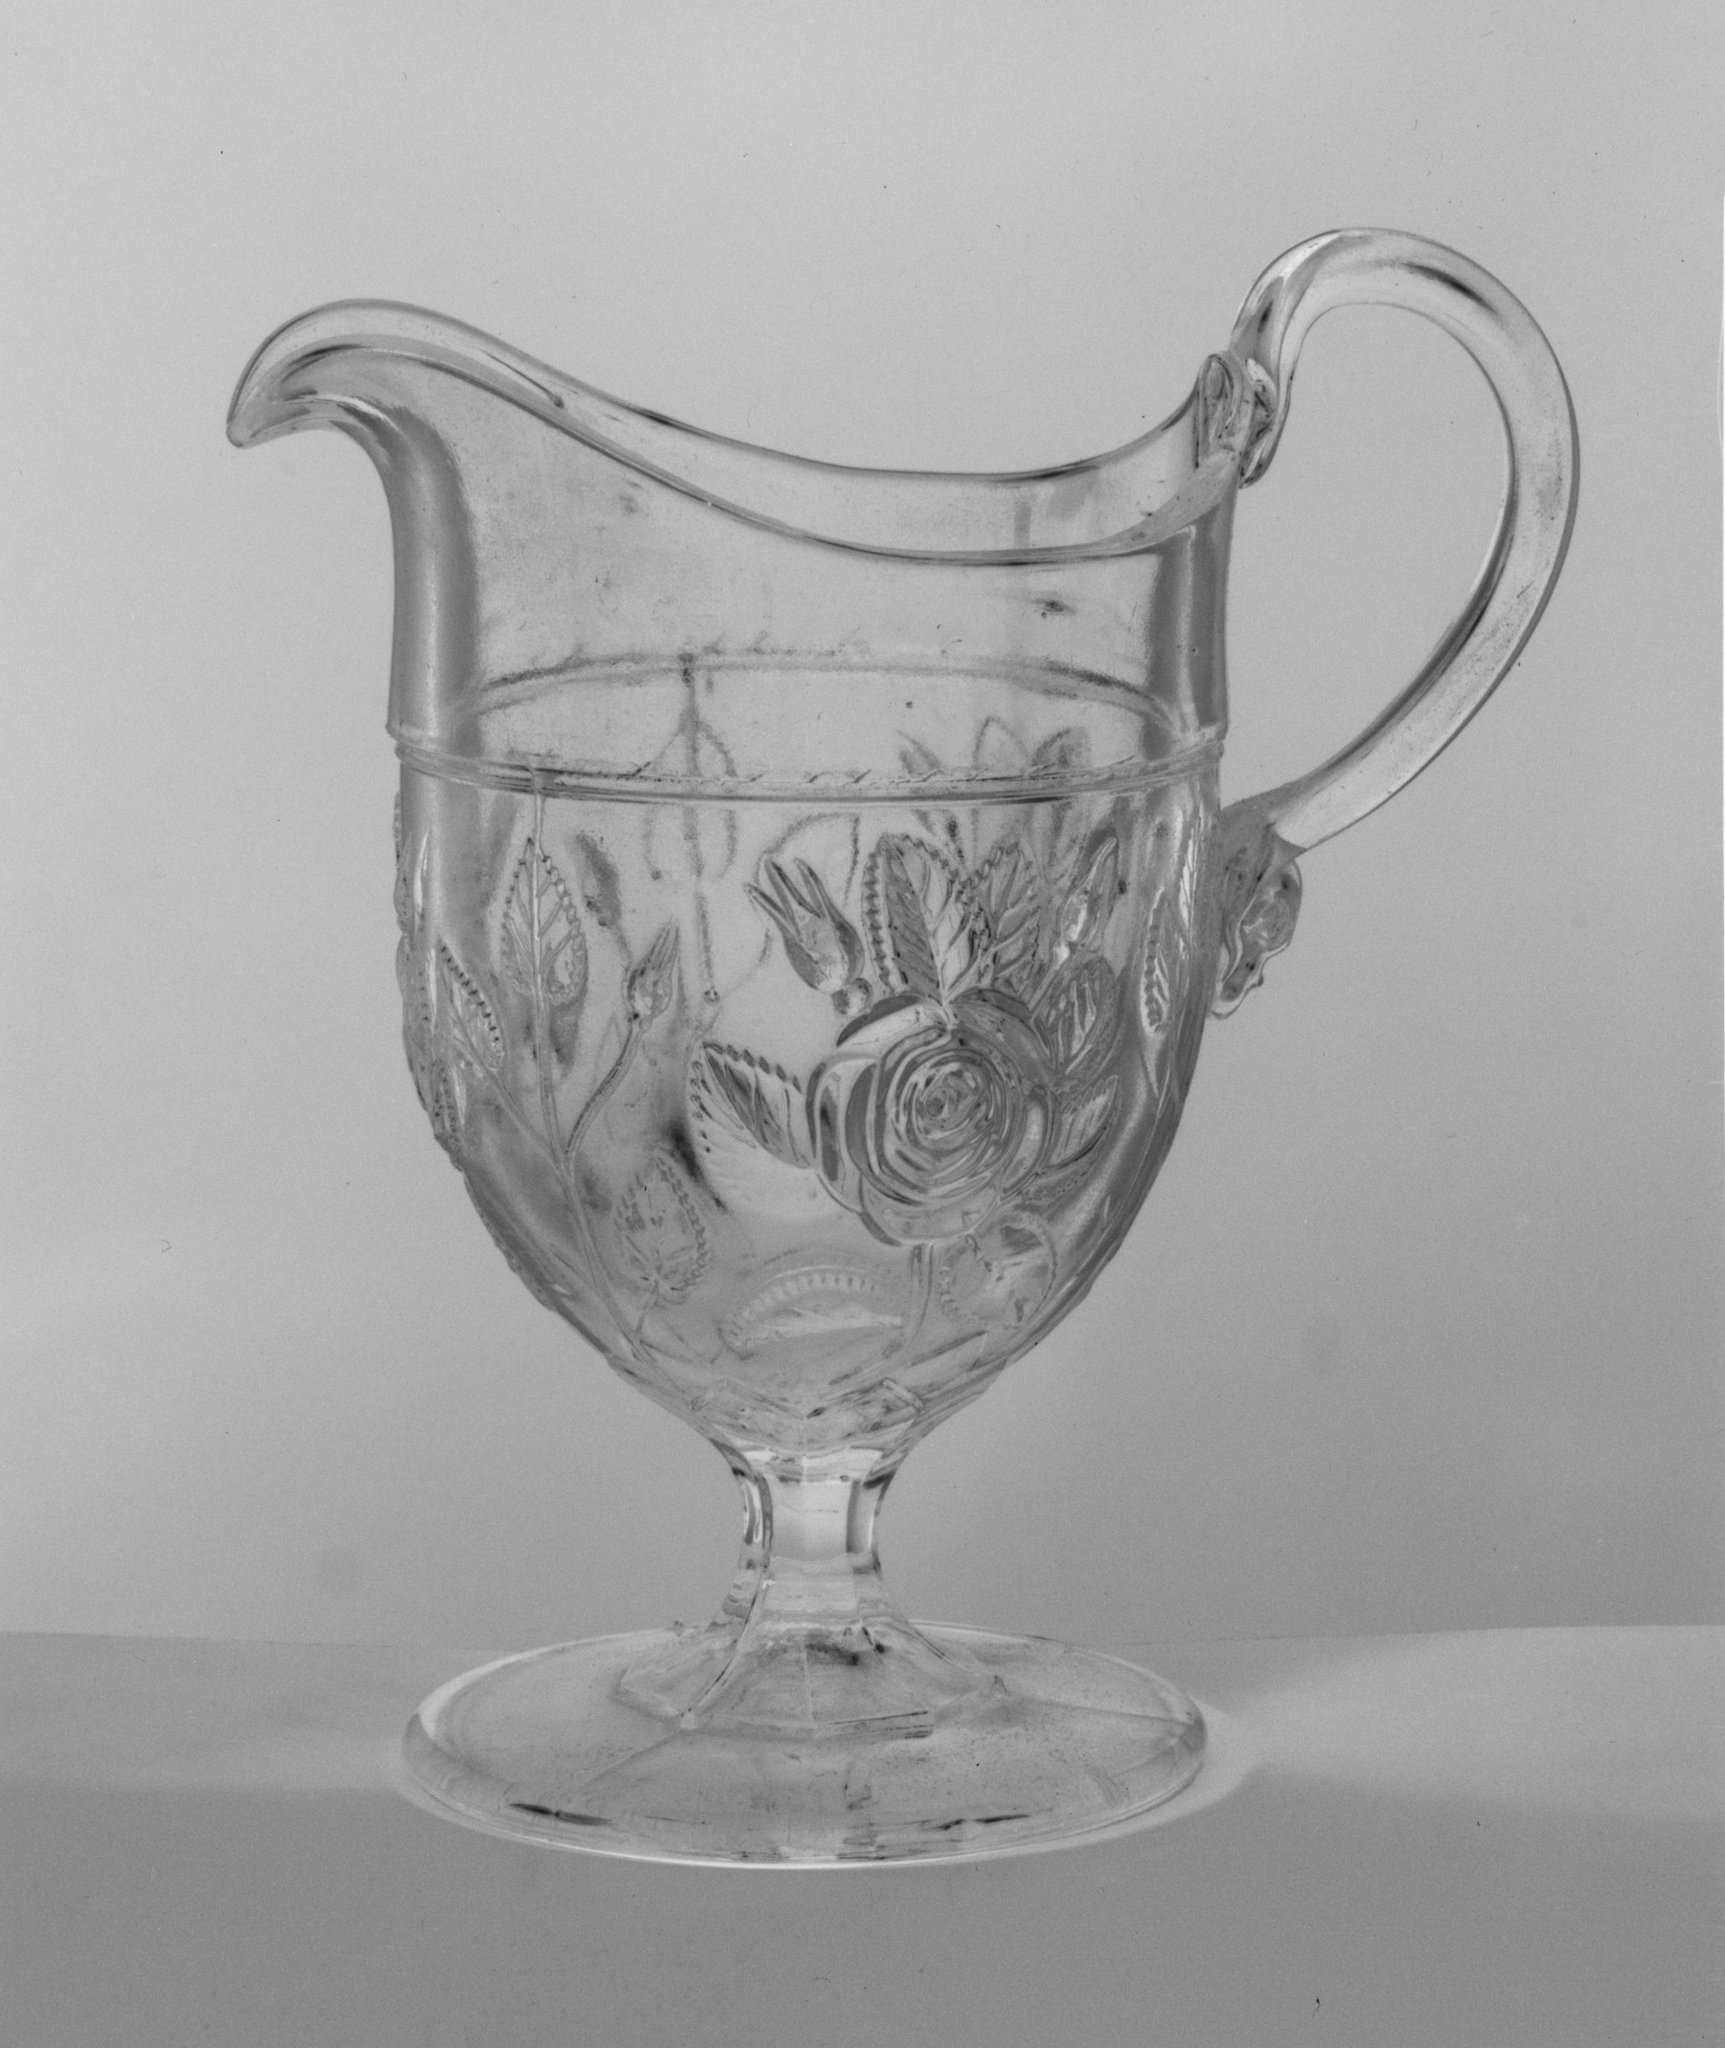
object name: cream pot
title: Creamer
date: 1875-1880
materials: glass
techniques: pressed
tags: flowers